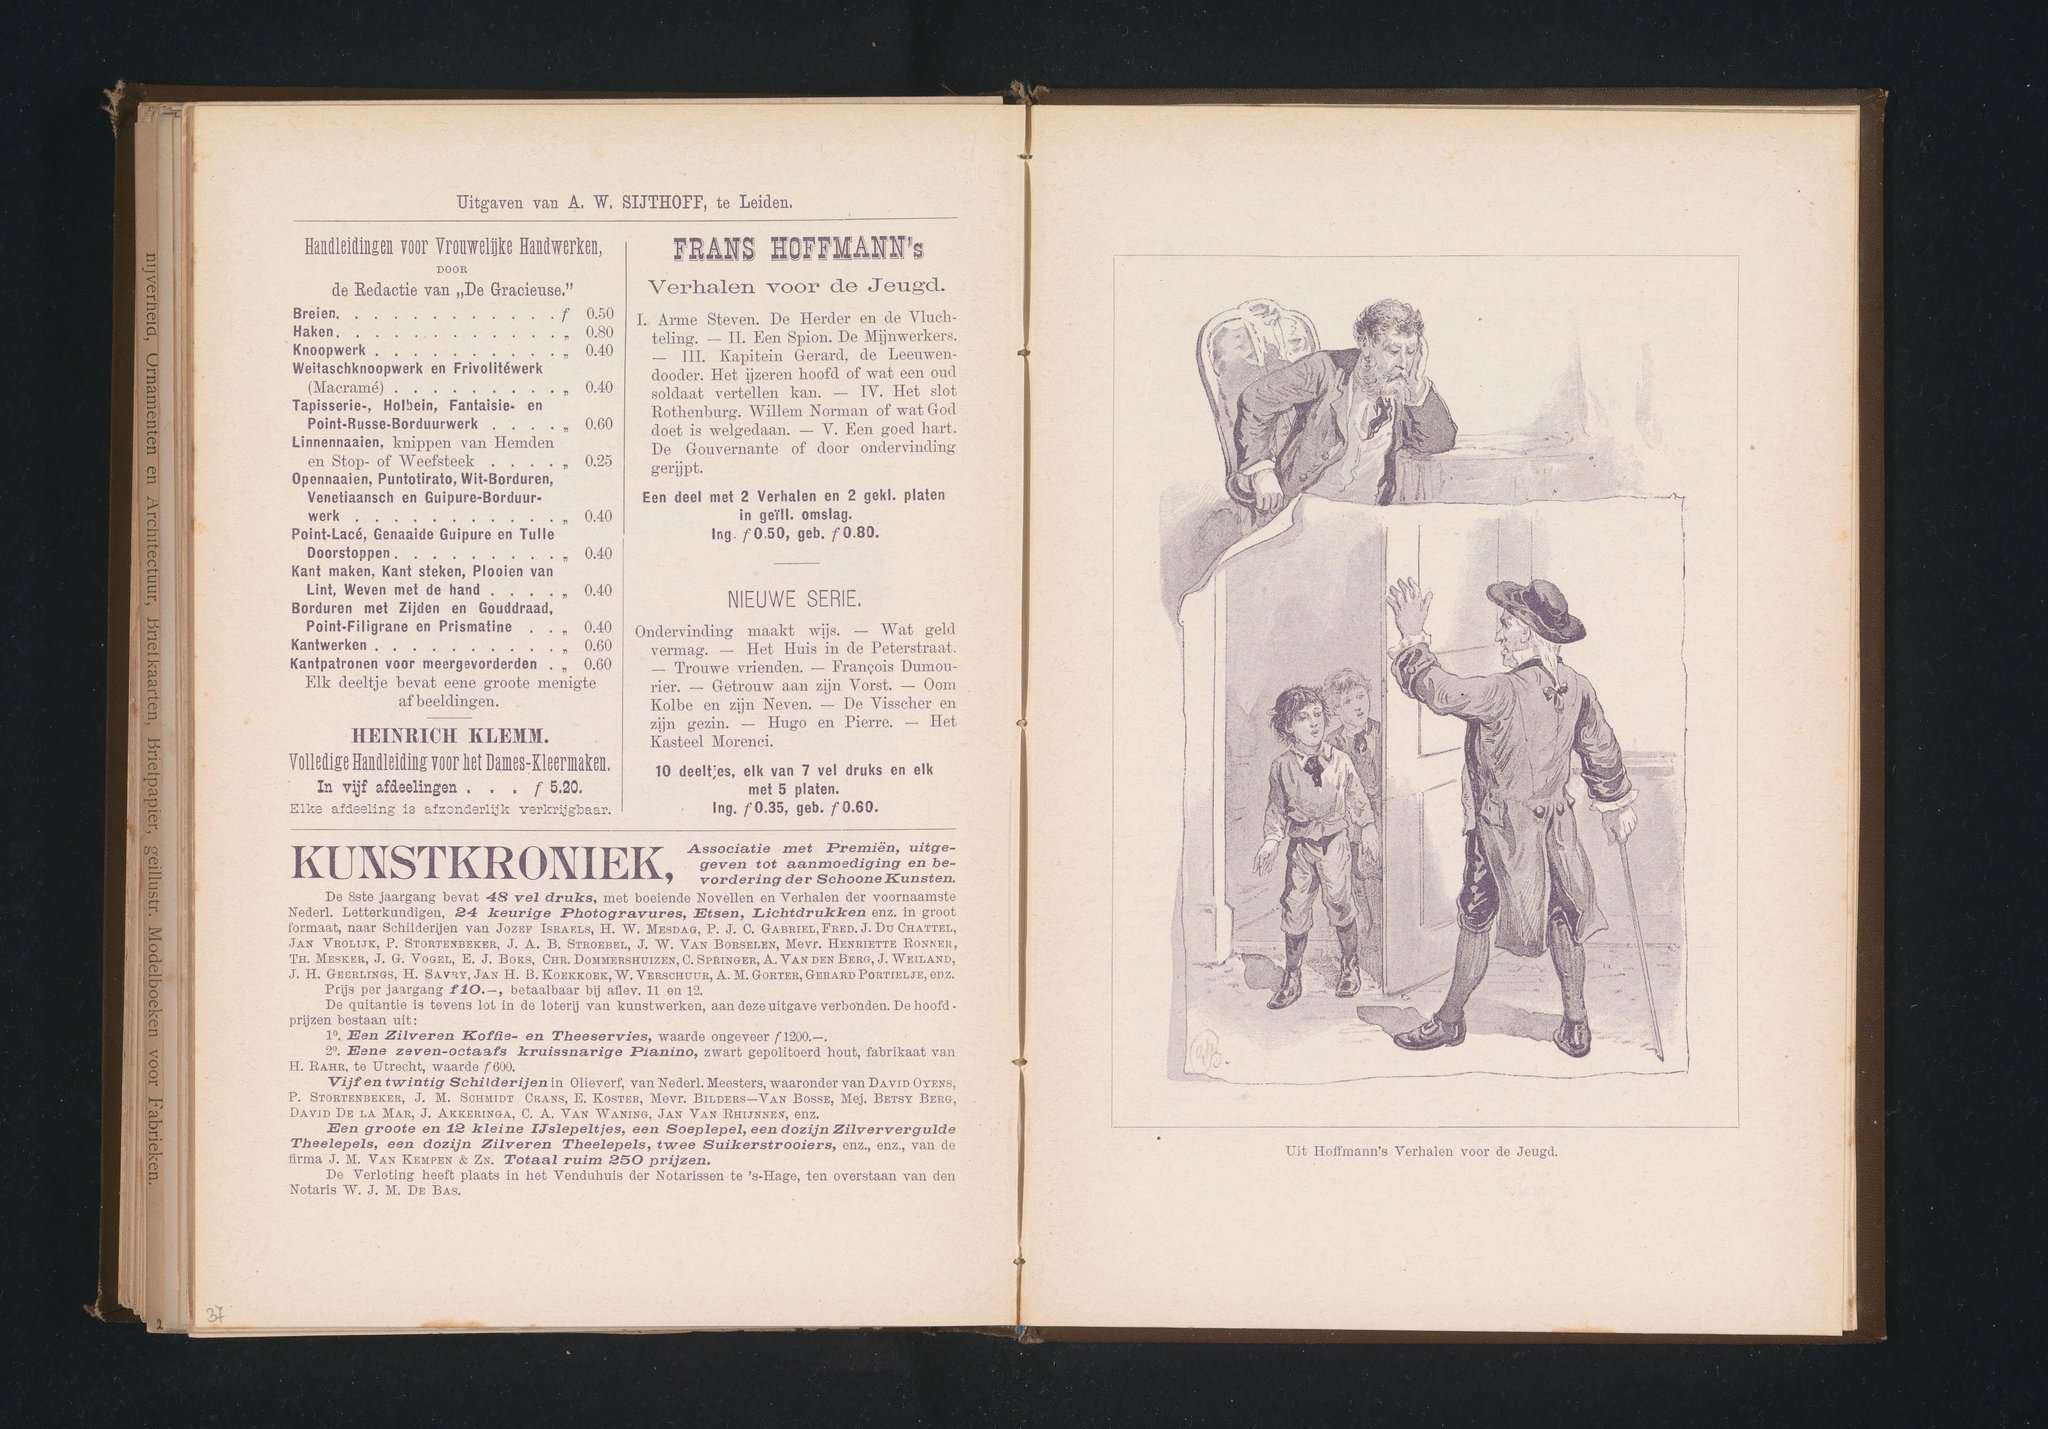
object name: reproduction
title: Reproductie van een ontwerp van een montage van twee afbeeldingen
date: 1887-1892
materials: paper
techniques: autotype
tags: sitting figure, adult man, child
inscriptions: inscription: ‘Uit Hoffmann's Verhalen voor de Jeugd.’, monogram: ‘[.]K’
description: Boven een man die aan tafel zit en naar beneden kijkt. Onder een man die twee kinderen in een open deur halt toeroept.